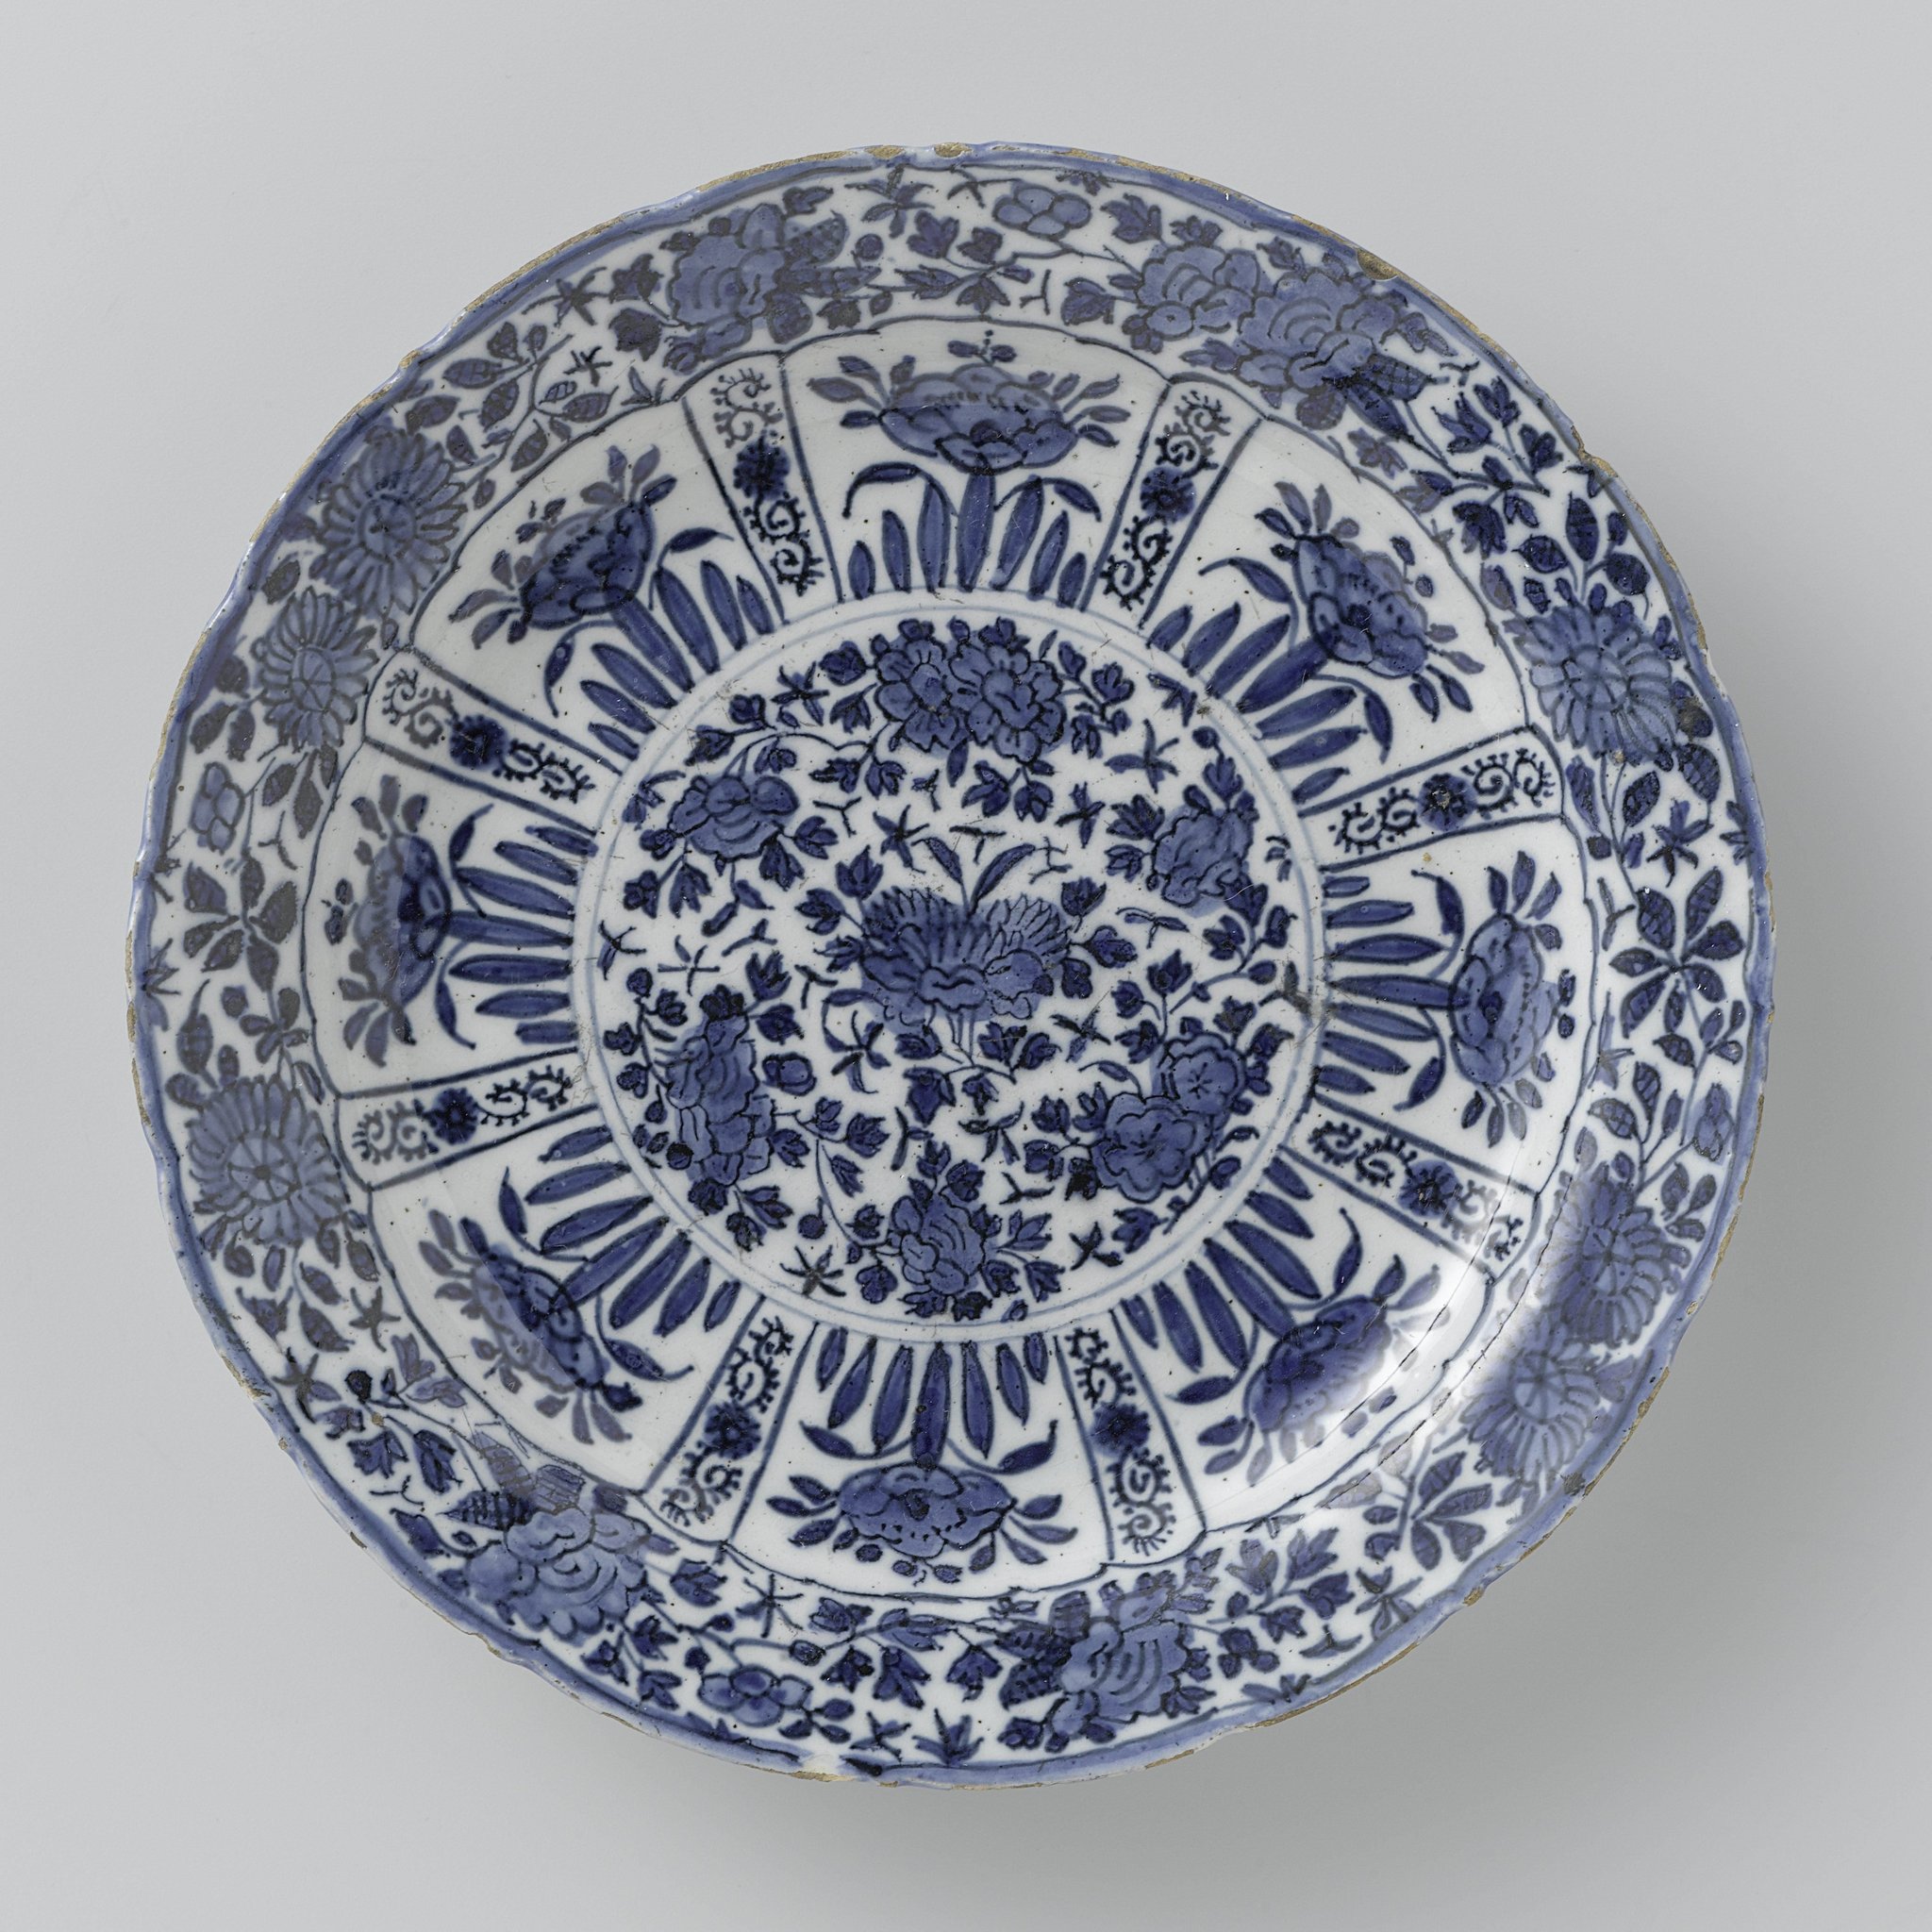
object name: plate dish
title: Bord van faience met bloemdecoratie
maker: adrianus kocx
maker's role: plateelbakker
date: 1690-1700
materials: earthenware, glaze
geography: delft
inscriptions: mark: ‘AK (ineen)’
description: Bord van faience met een bloemdecoratie naar voorbeeld van het Chinese porselein uit de periode Kangxi.